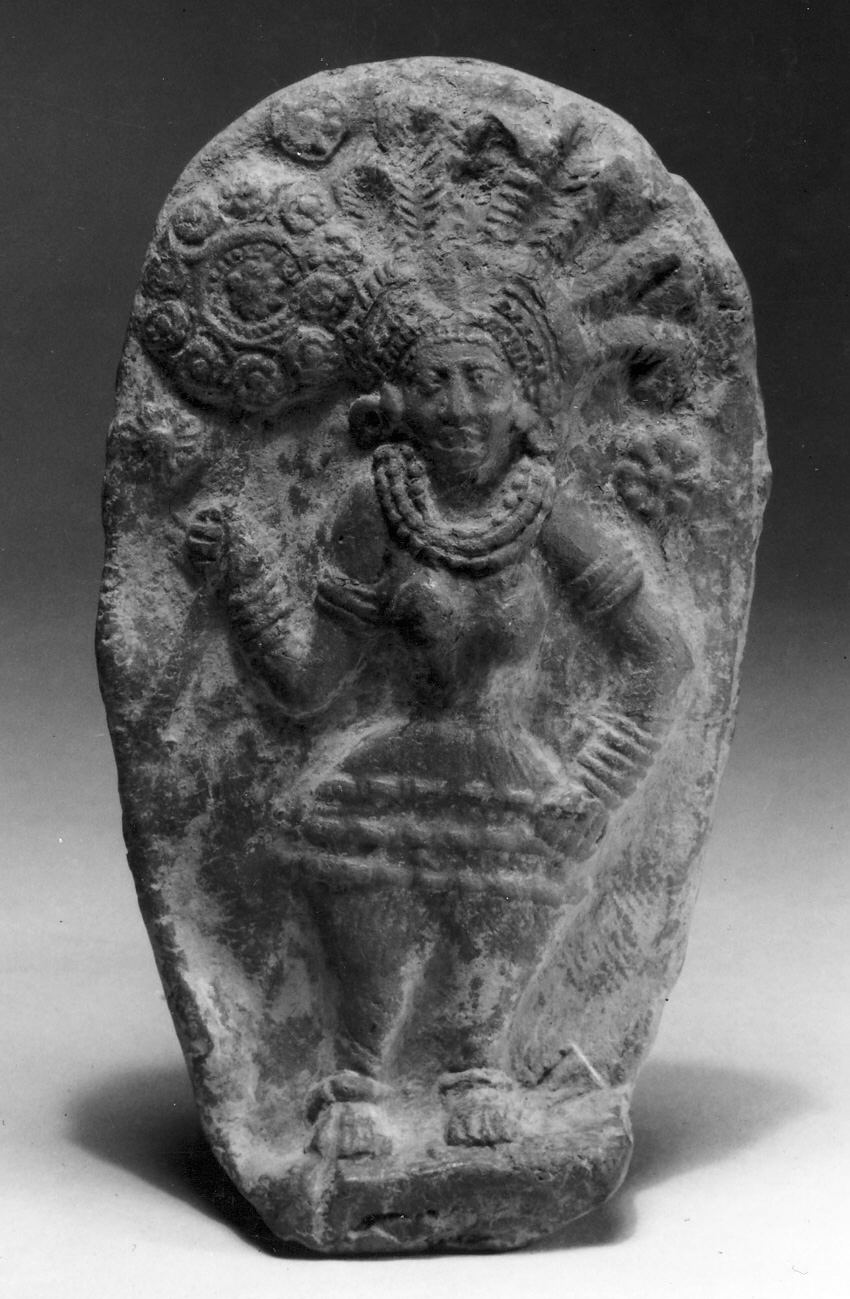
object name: plaque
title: Plaque with Standing Goddess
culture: indian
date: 100 BCE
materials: terracotta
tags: maurya,mauryan,goddess